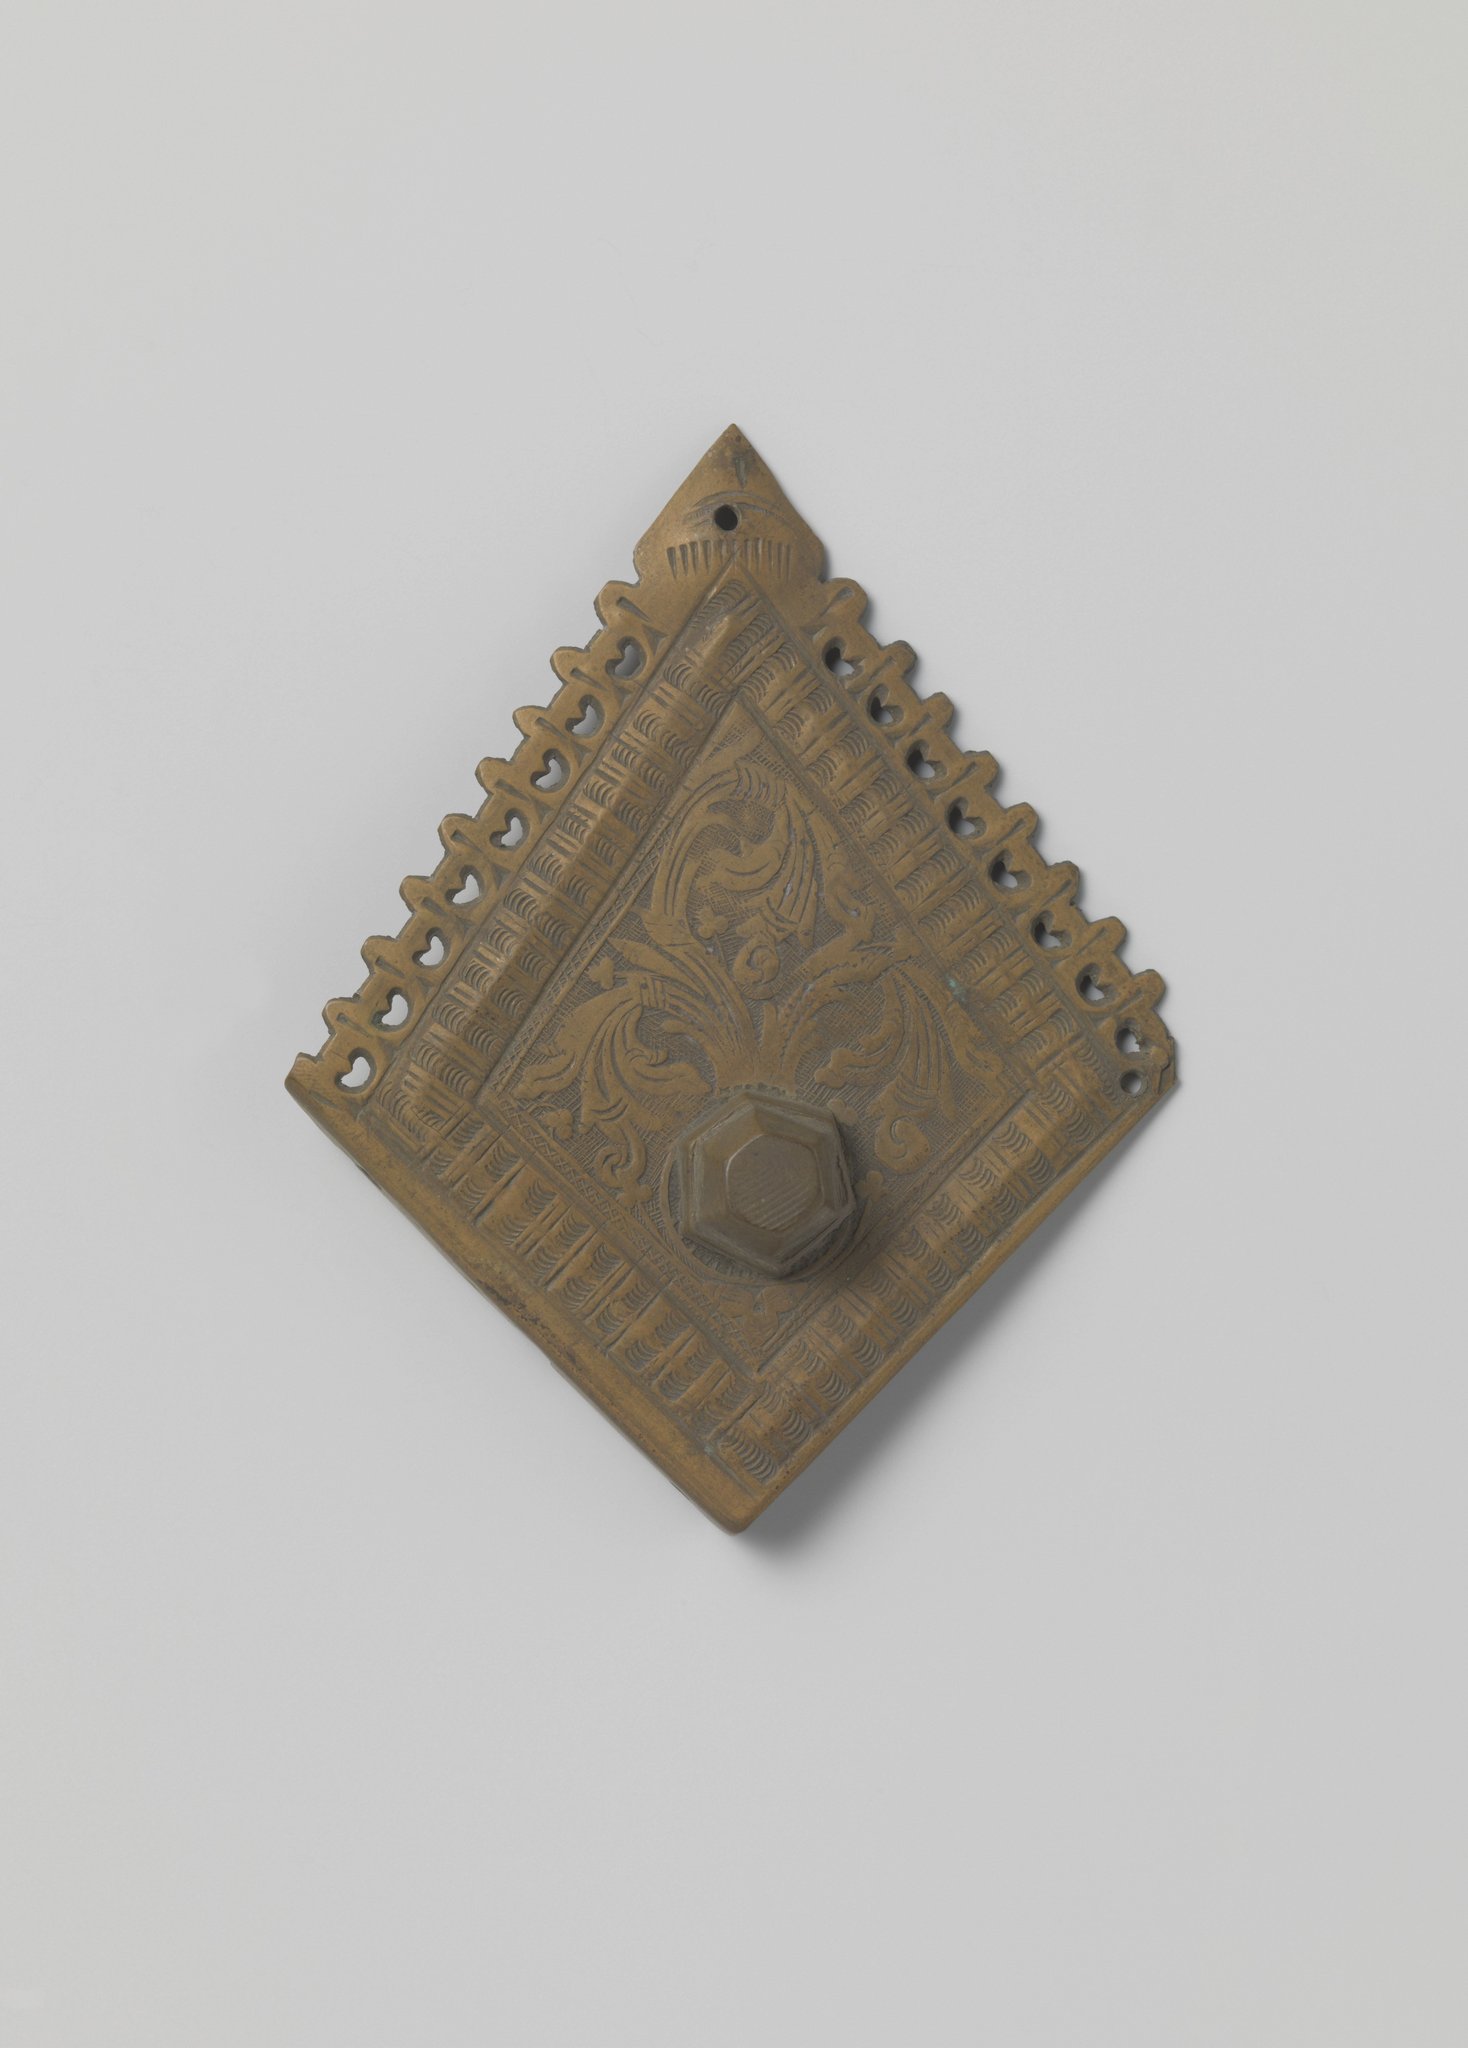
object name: binding finishing hardware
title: Beslag van een missaalband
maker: Anonymous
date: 1450-1500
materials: brass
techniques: cutting, engraving, punching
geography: germany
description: Tien beslagdelen van een missaalband, van messing. De tien delen zijn uit koperplaat gesneden, gedreven, gegraveerd en gesponst bewerkt. Op ieder van hen is een koperen knop met zeven facetten geklonken. Zij zijn voorzien van gaatjes op de hoeken of langs de rand om nagels te kunnen inslaan, waarmee zij op de boekband waren bevetstigd. Vier hoekstukken hebben aan twee kanten een naar achter omgeslagen rand. De overige vier hebben dat slechts aan de boven- of onderkant (deze waren geplaatst tegen de rug van het boek). Van ieder hoekstuk zijn twee kanten kanten afgezet met een open rand van kruisbloemen. Het veld in het midden wordt ingenomen door drie gestilleerde ranken. Het ornament op de middenstukken bestaat op de hoeken uit een plant met drie bladeren en twee bloemen in een pot. De vier gedeelten daartussen worden ingenomen door fantasiegedrochten.